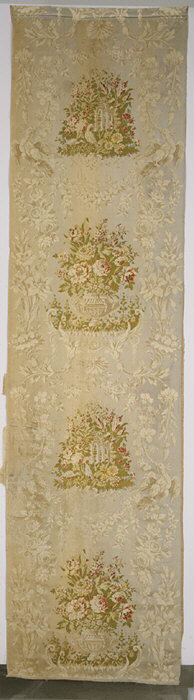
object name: length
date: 1784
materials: silk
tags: birds,flowers